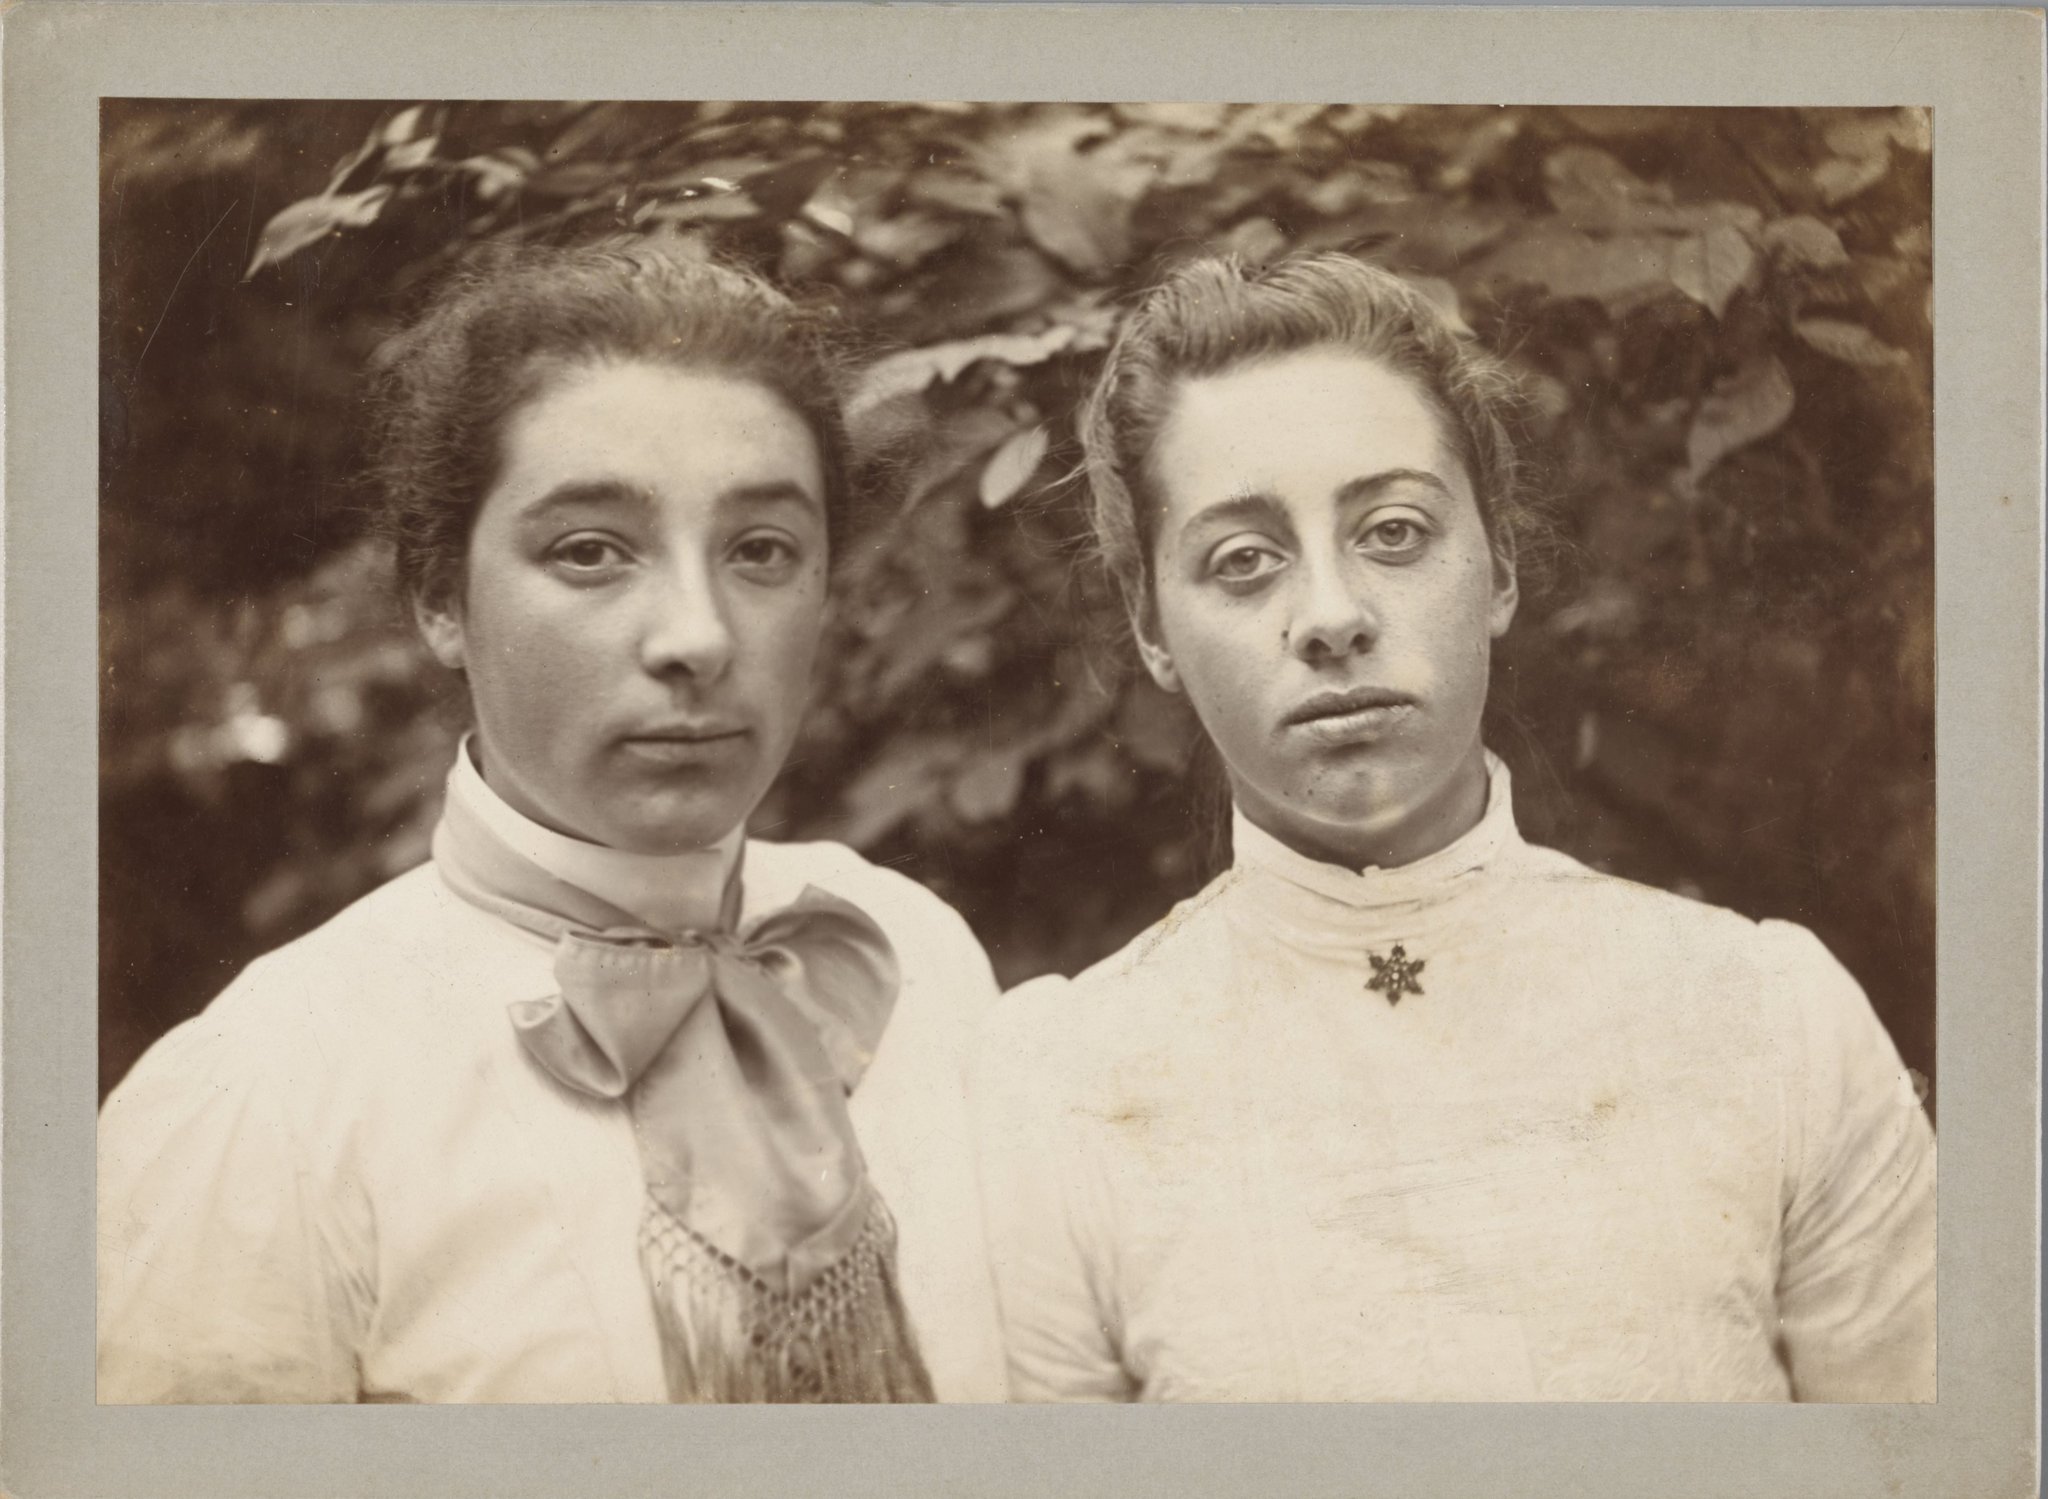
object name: photograph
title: Liesbeth Quarles v. Ufford en Dora Reub-Arntzenius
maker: willem witsen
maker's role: draughtsman, painter, print maker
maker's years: 1860-1923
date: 1860-1915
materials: cardboard, paper, photographic support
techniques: gelatin silver print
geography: amsterdam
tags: liesbeth quarles van ufford-arntzenius